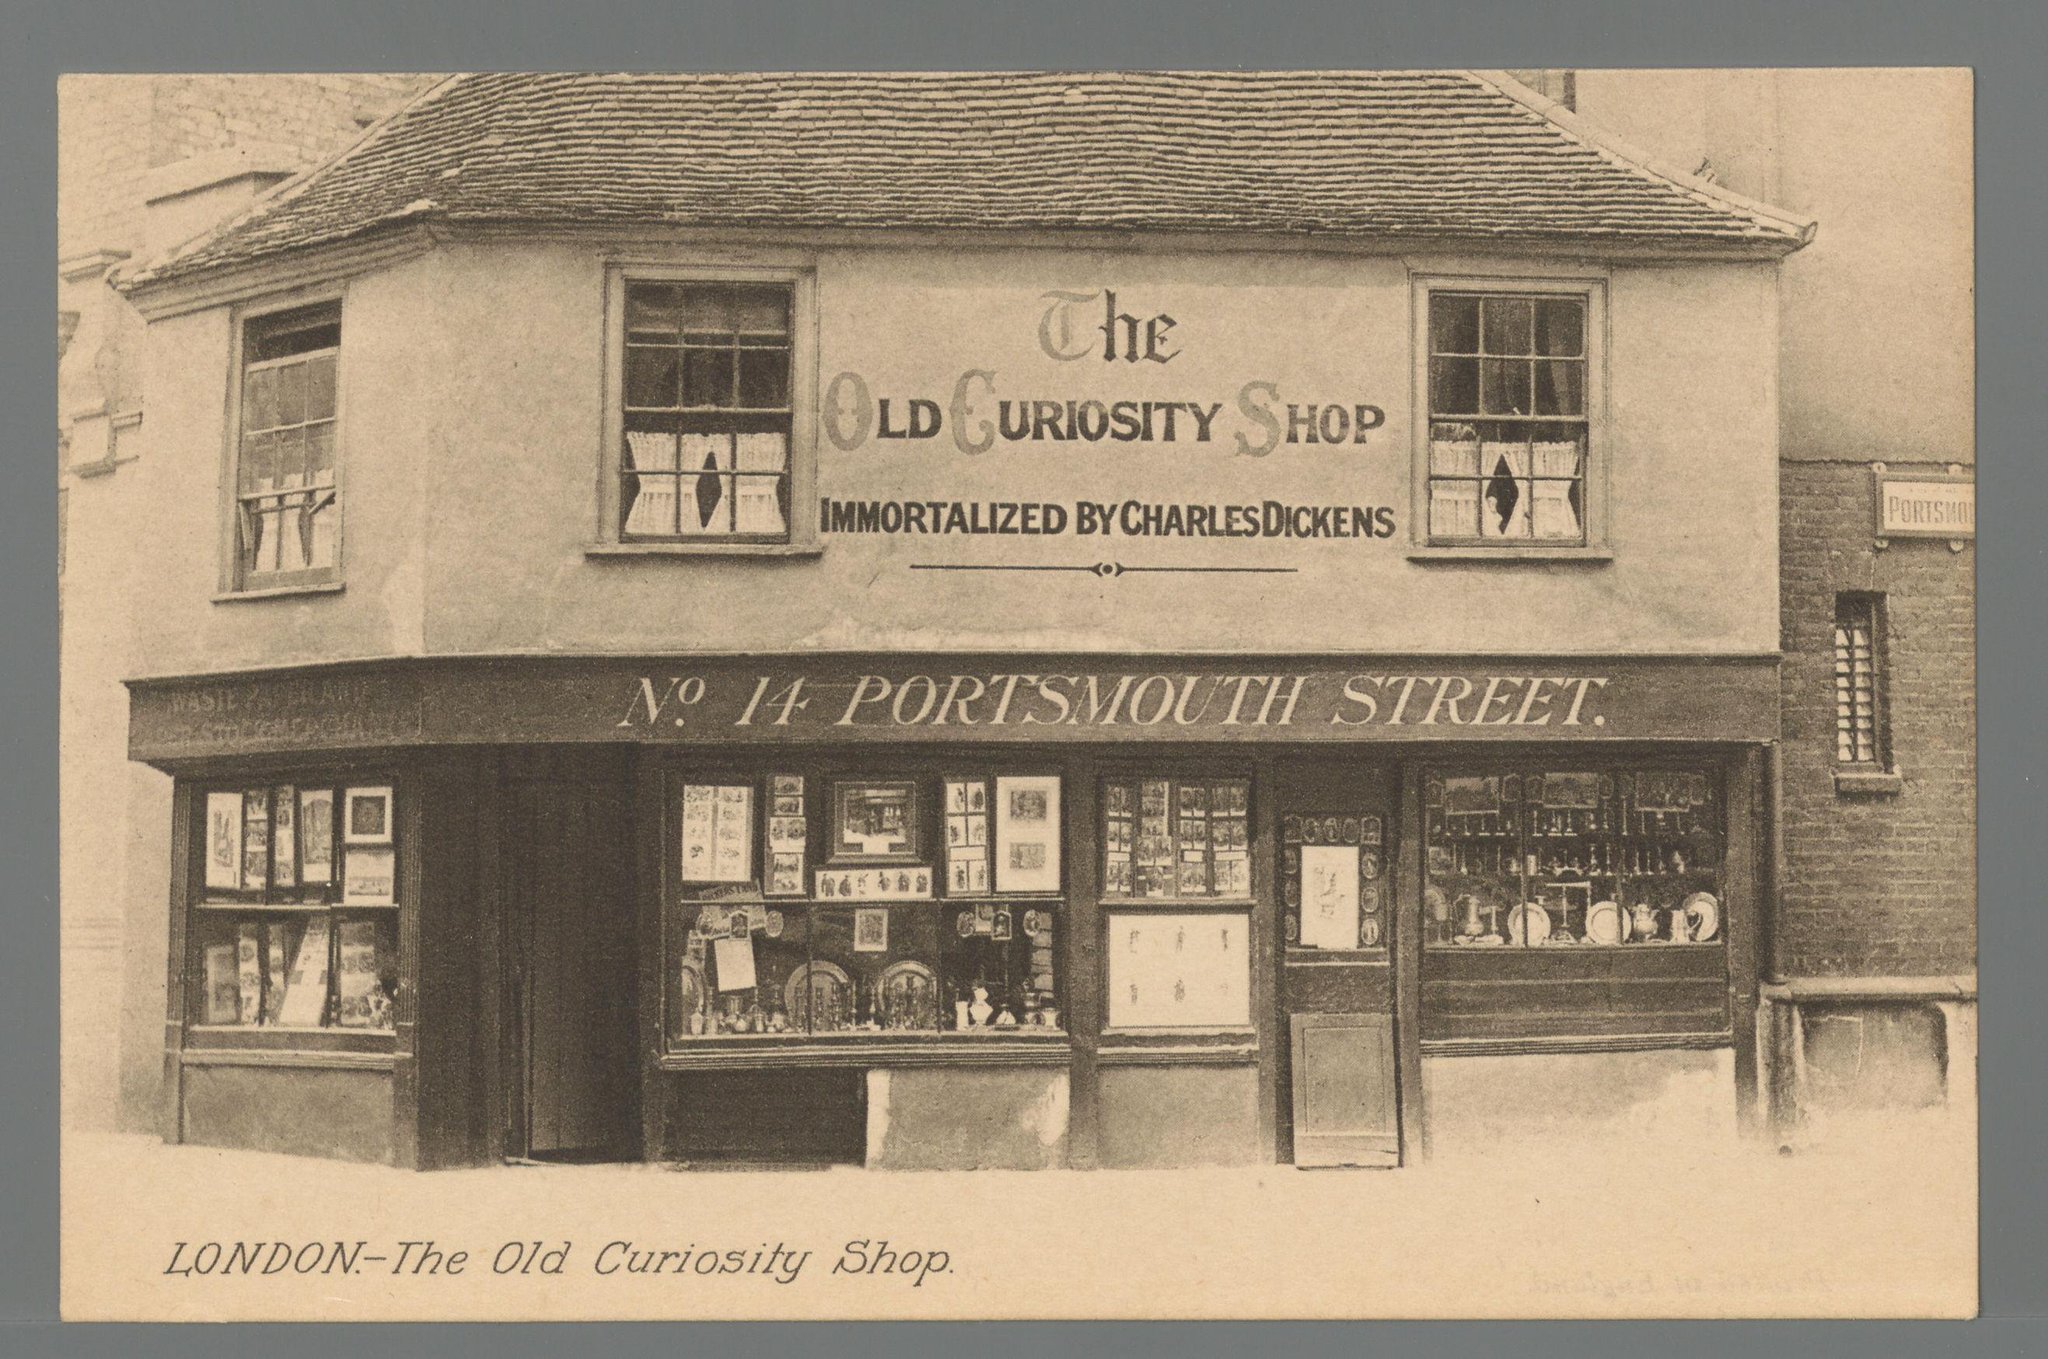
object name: photomechanical print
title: London.-The Old Curiosity Shop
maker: Anonymous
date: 1908-1930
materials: cardboard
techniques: rotogravure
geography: london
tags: shop, store, london